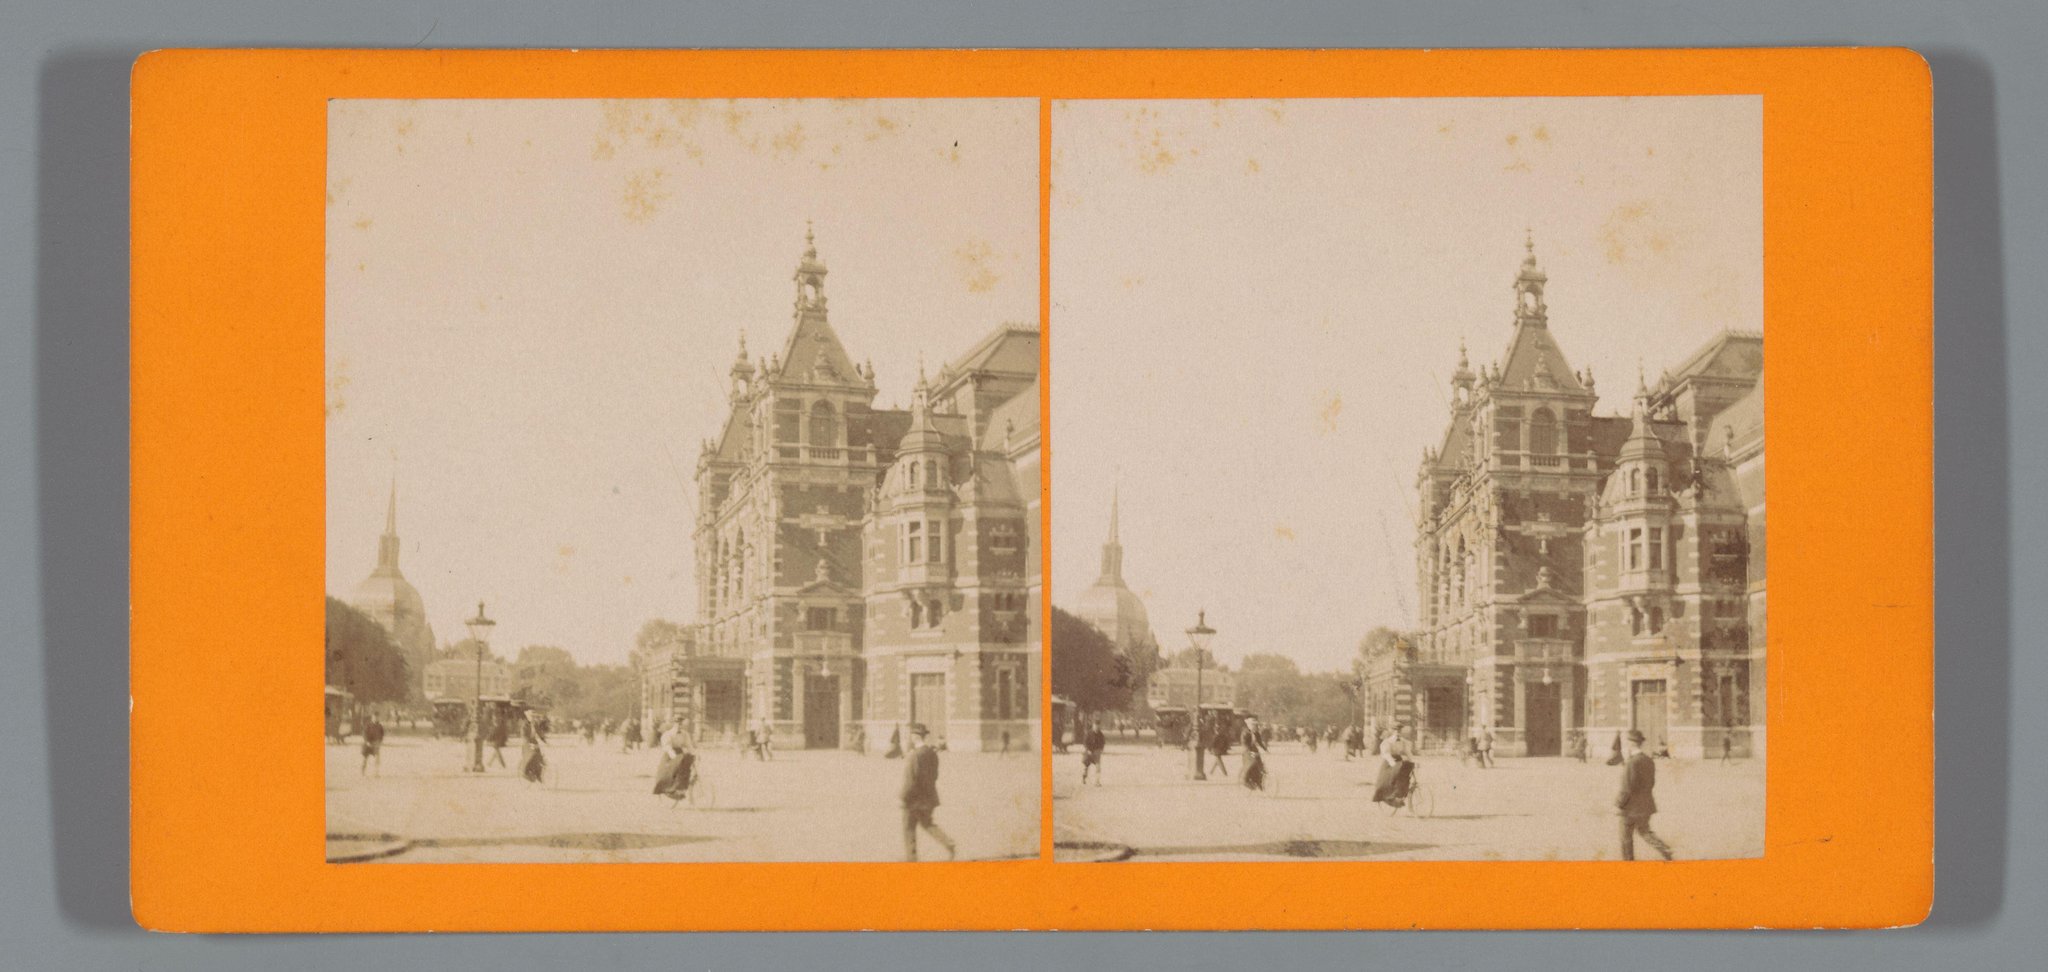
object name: stereograph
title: Leidseplein met de Stadsschouwburg en op de achtergrond de Koepelkerk, Amsterdam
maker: Anonymous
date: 1898-1918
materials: cardboard, paper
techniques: albumen print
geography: amsterdam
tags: square, place, circus, etc., theatre (building)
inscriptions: number: ‘7’, retailer's mark: ‘Gebr. Douwes/ Ateliers/ Warmoesstraat 73./ Amsterdam’, inscription: ‘Amsterdam/ Stadsschouwburg’